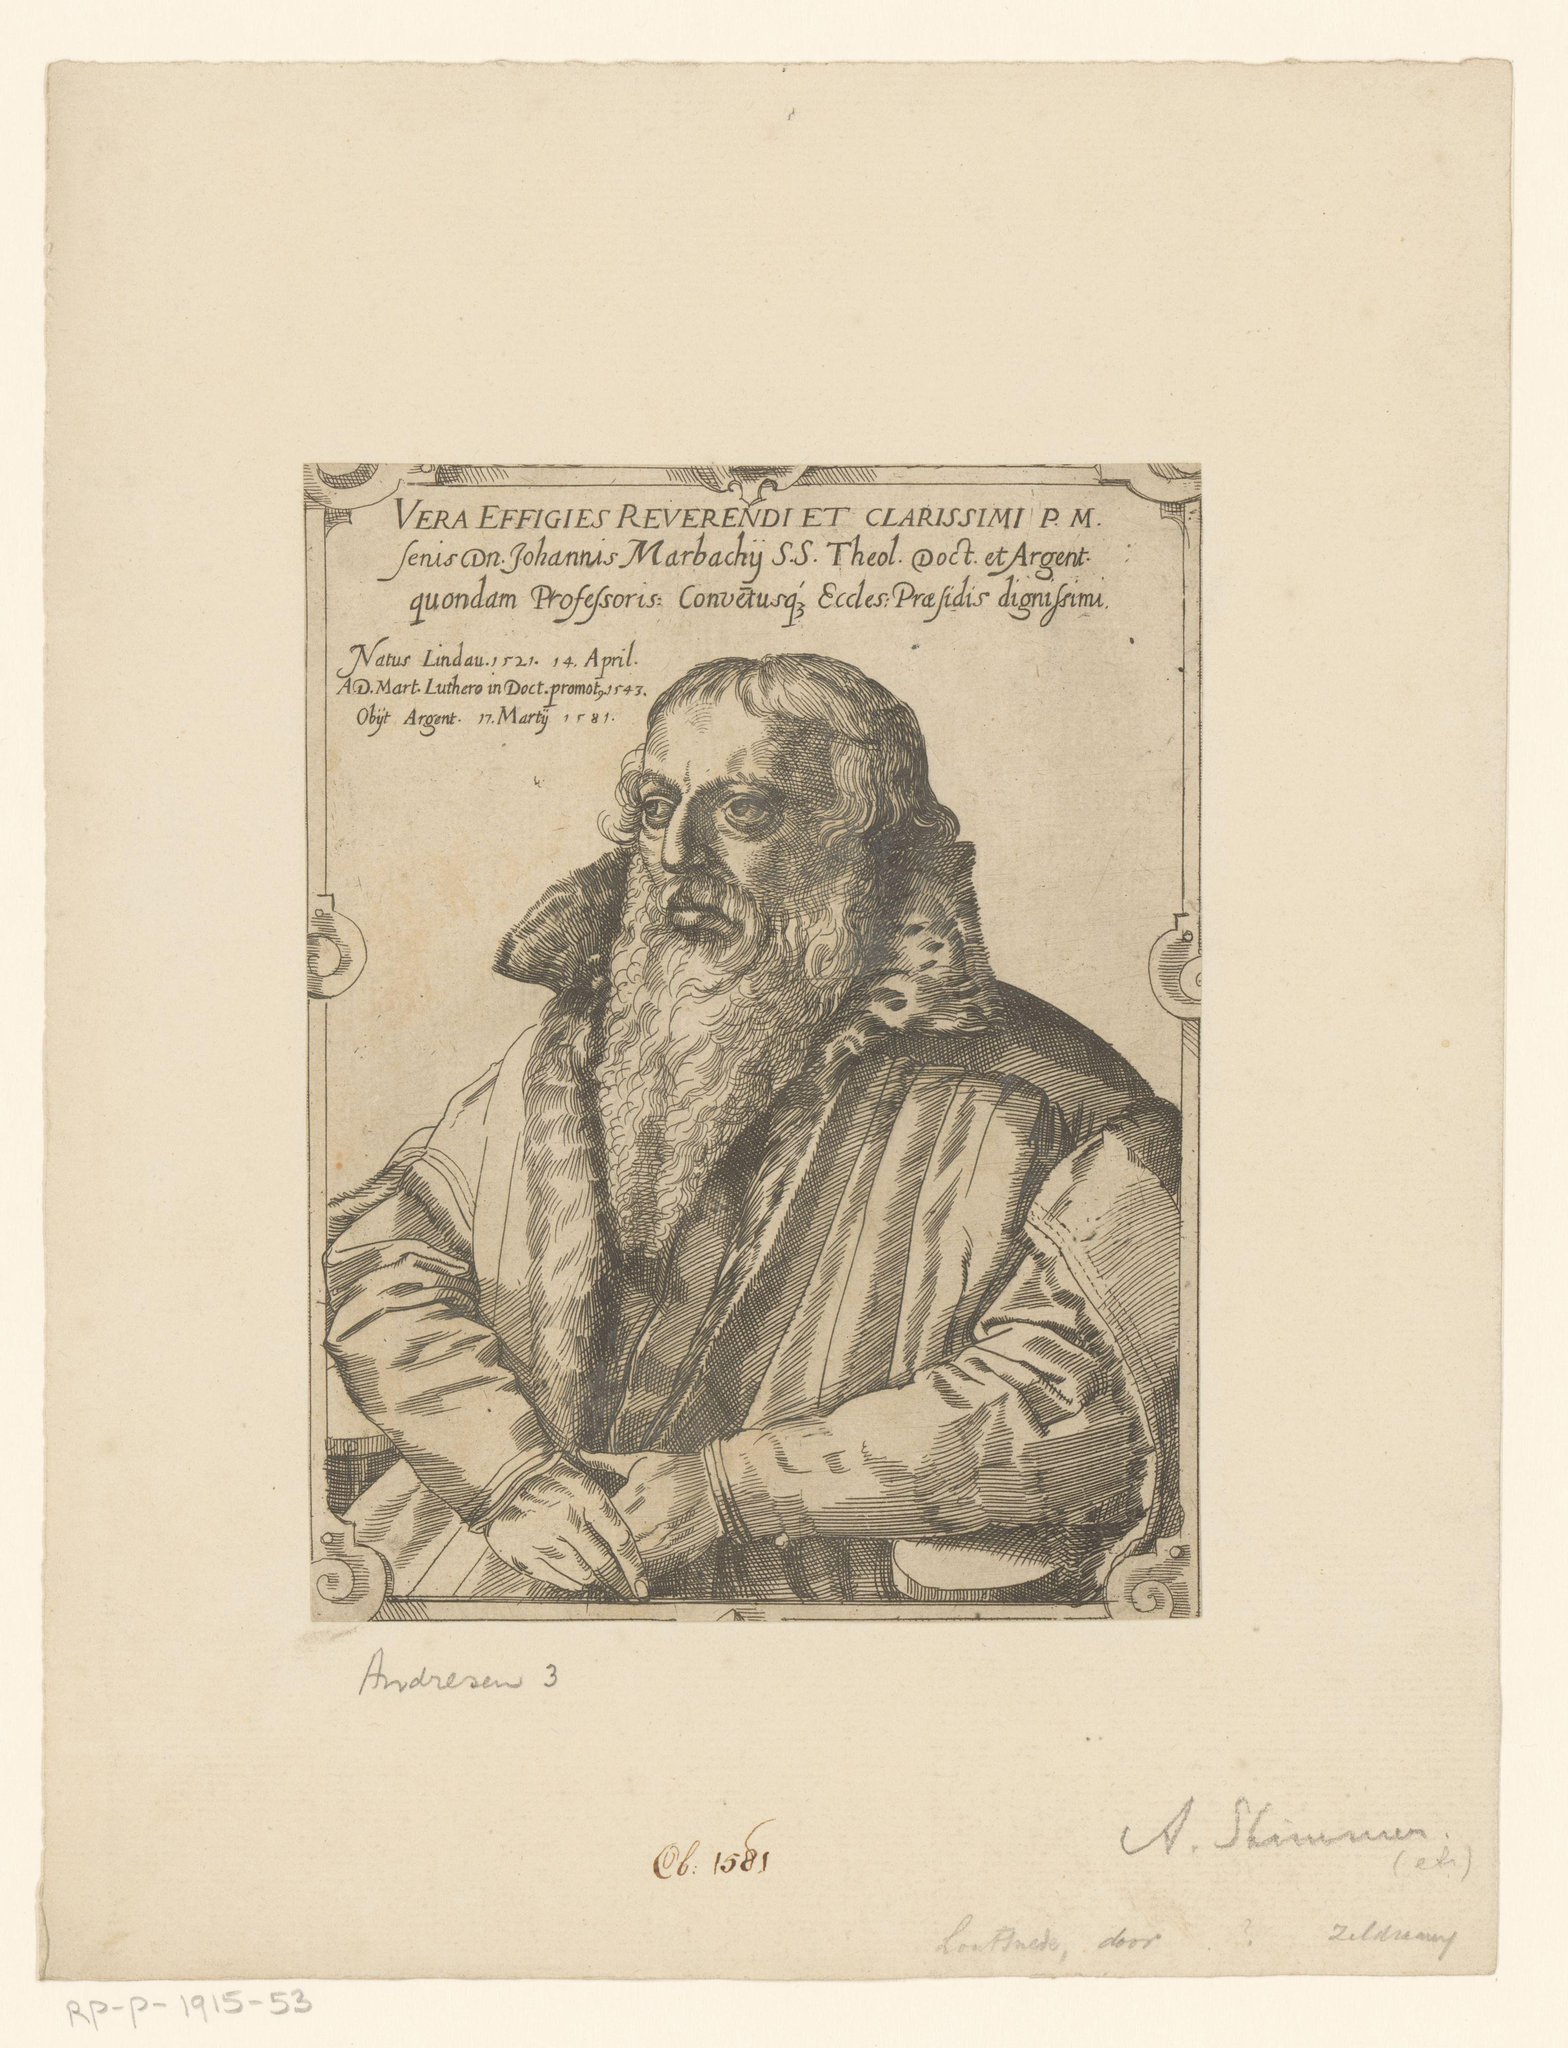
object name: print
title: Portret van Johann Marbach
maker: abel stimmer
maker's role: draughtsman, painter, print maker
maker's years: 1542-1606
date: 1581-1606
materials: paper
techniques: engraving, etching, intaglio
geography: germany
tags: historical persons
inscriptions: collector's mark: Lugt 2228